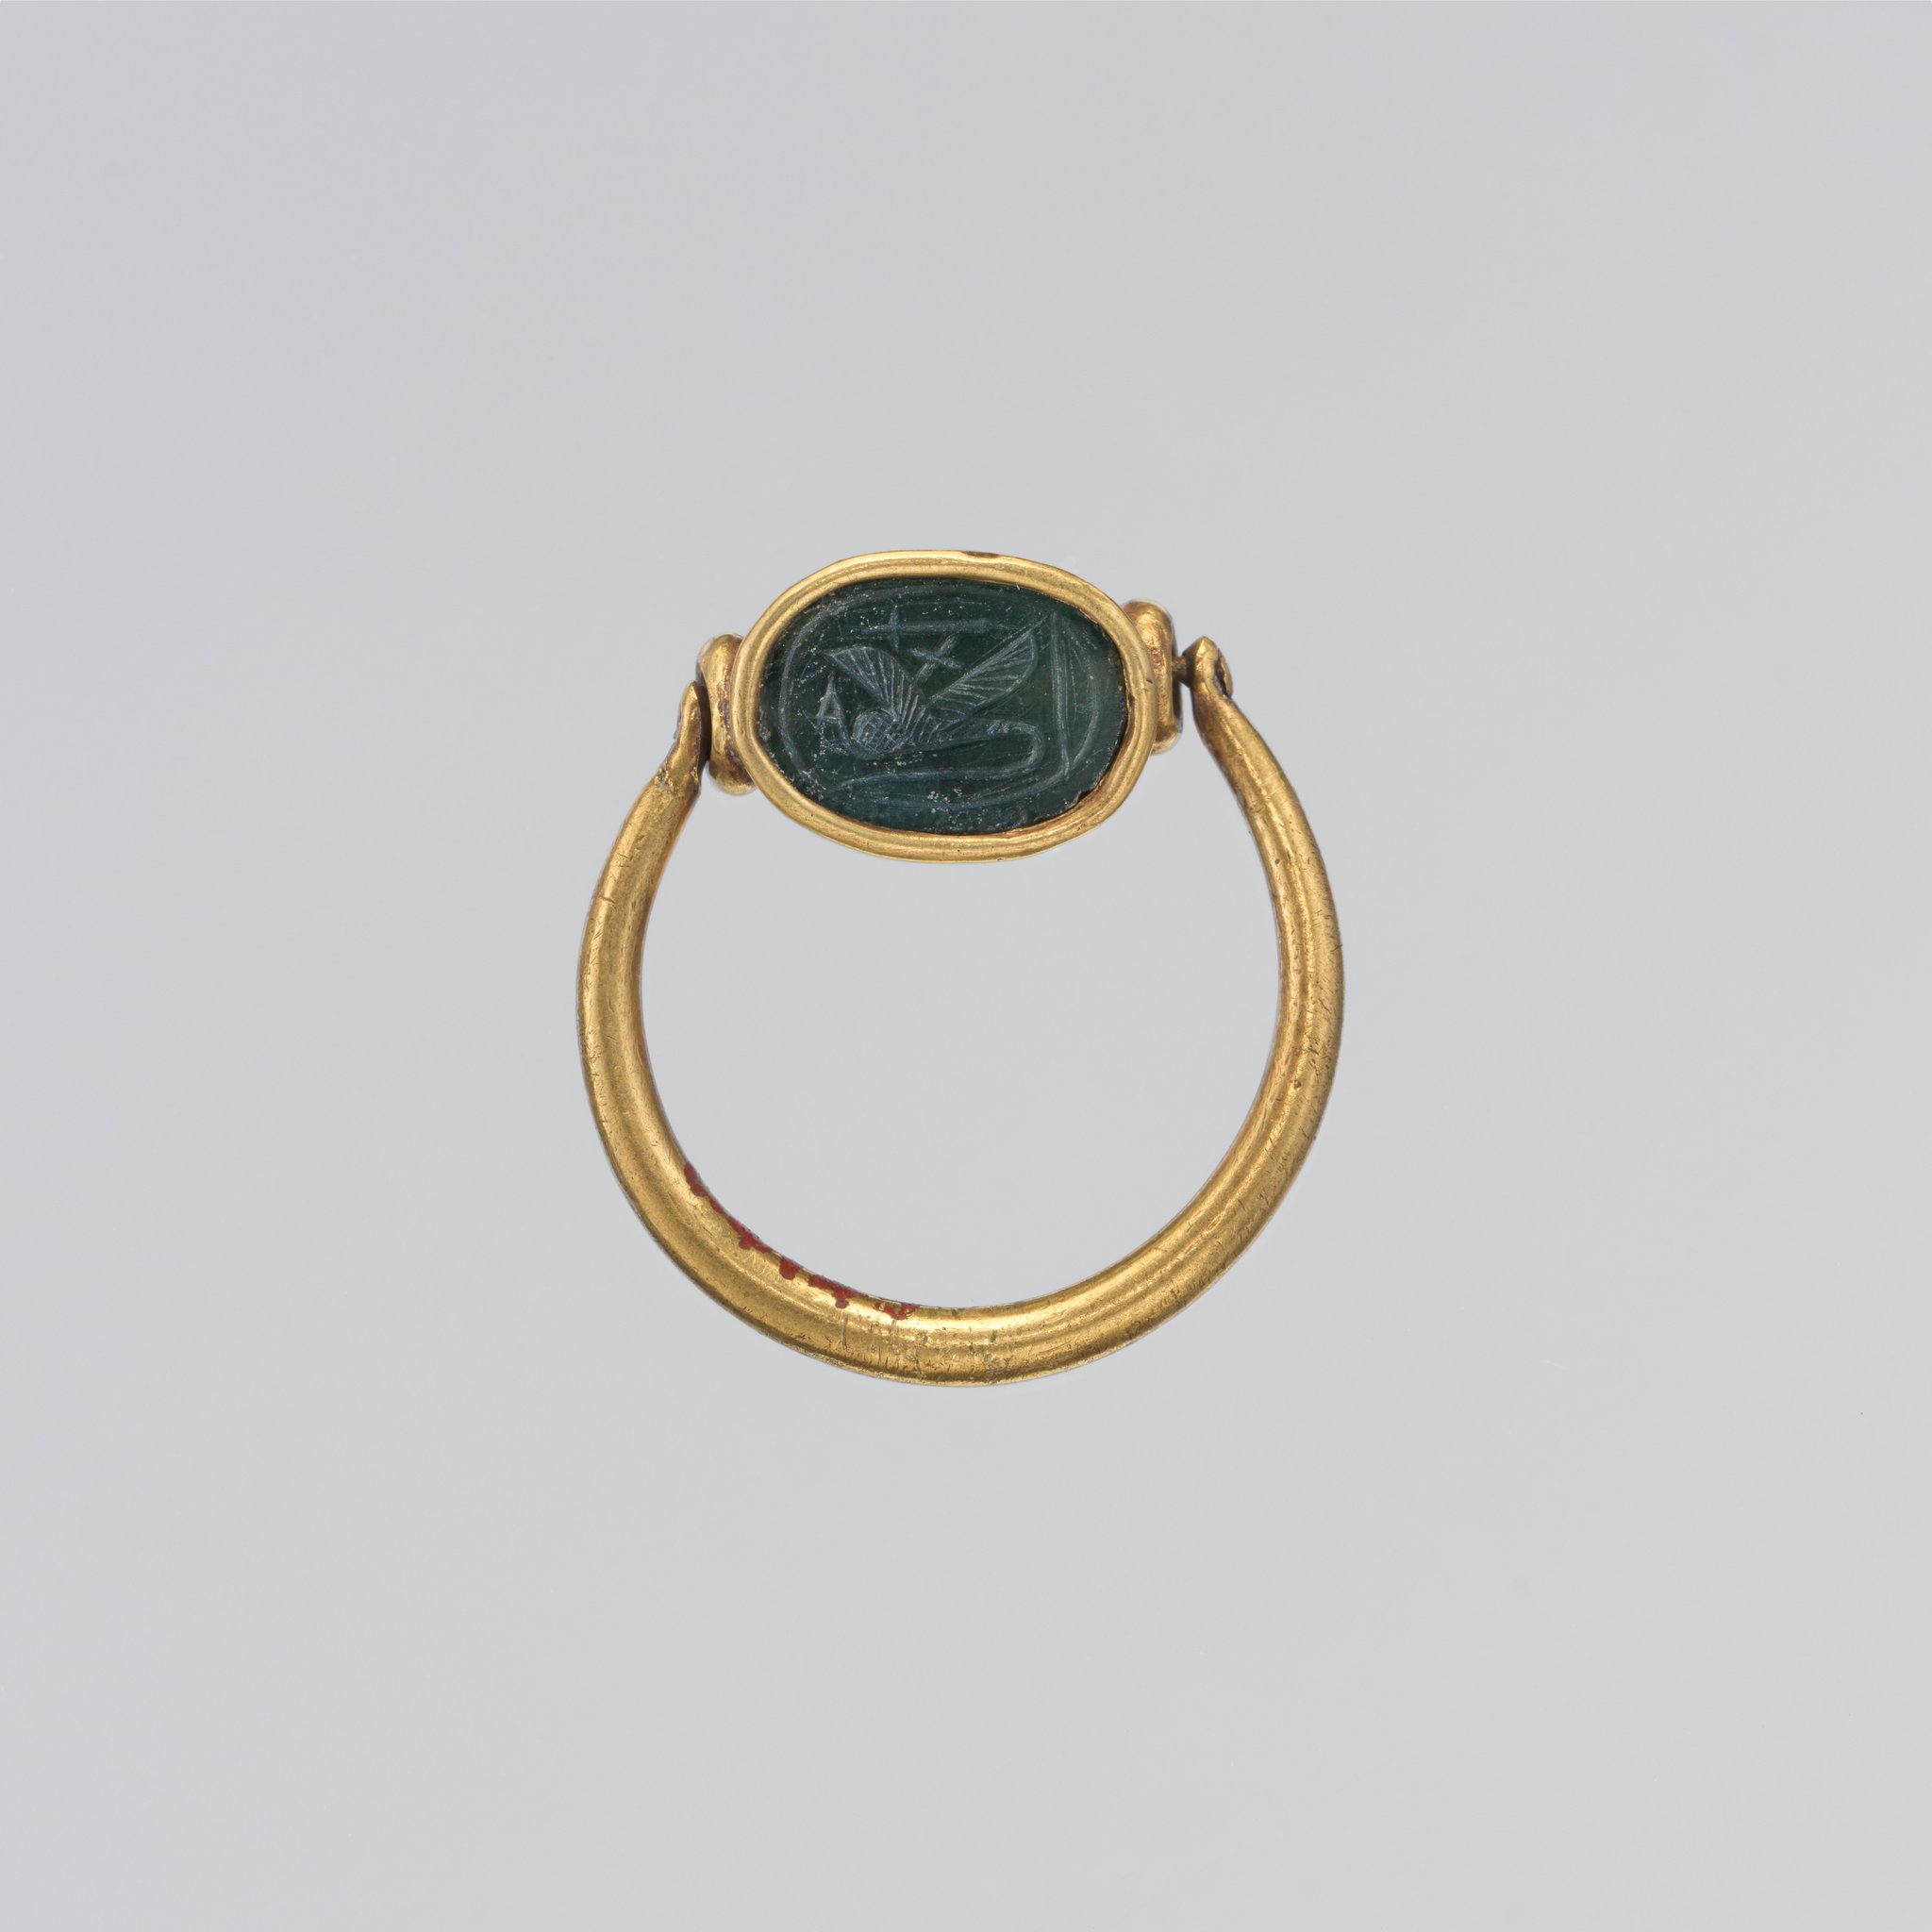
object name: ring with scaraboid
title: Gold ring with green jasper scaraboid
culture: cypriot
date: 500-401 BCE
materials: gold, jasper